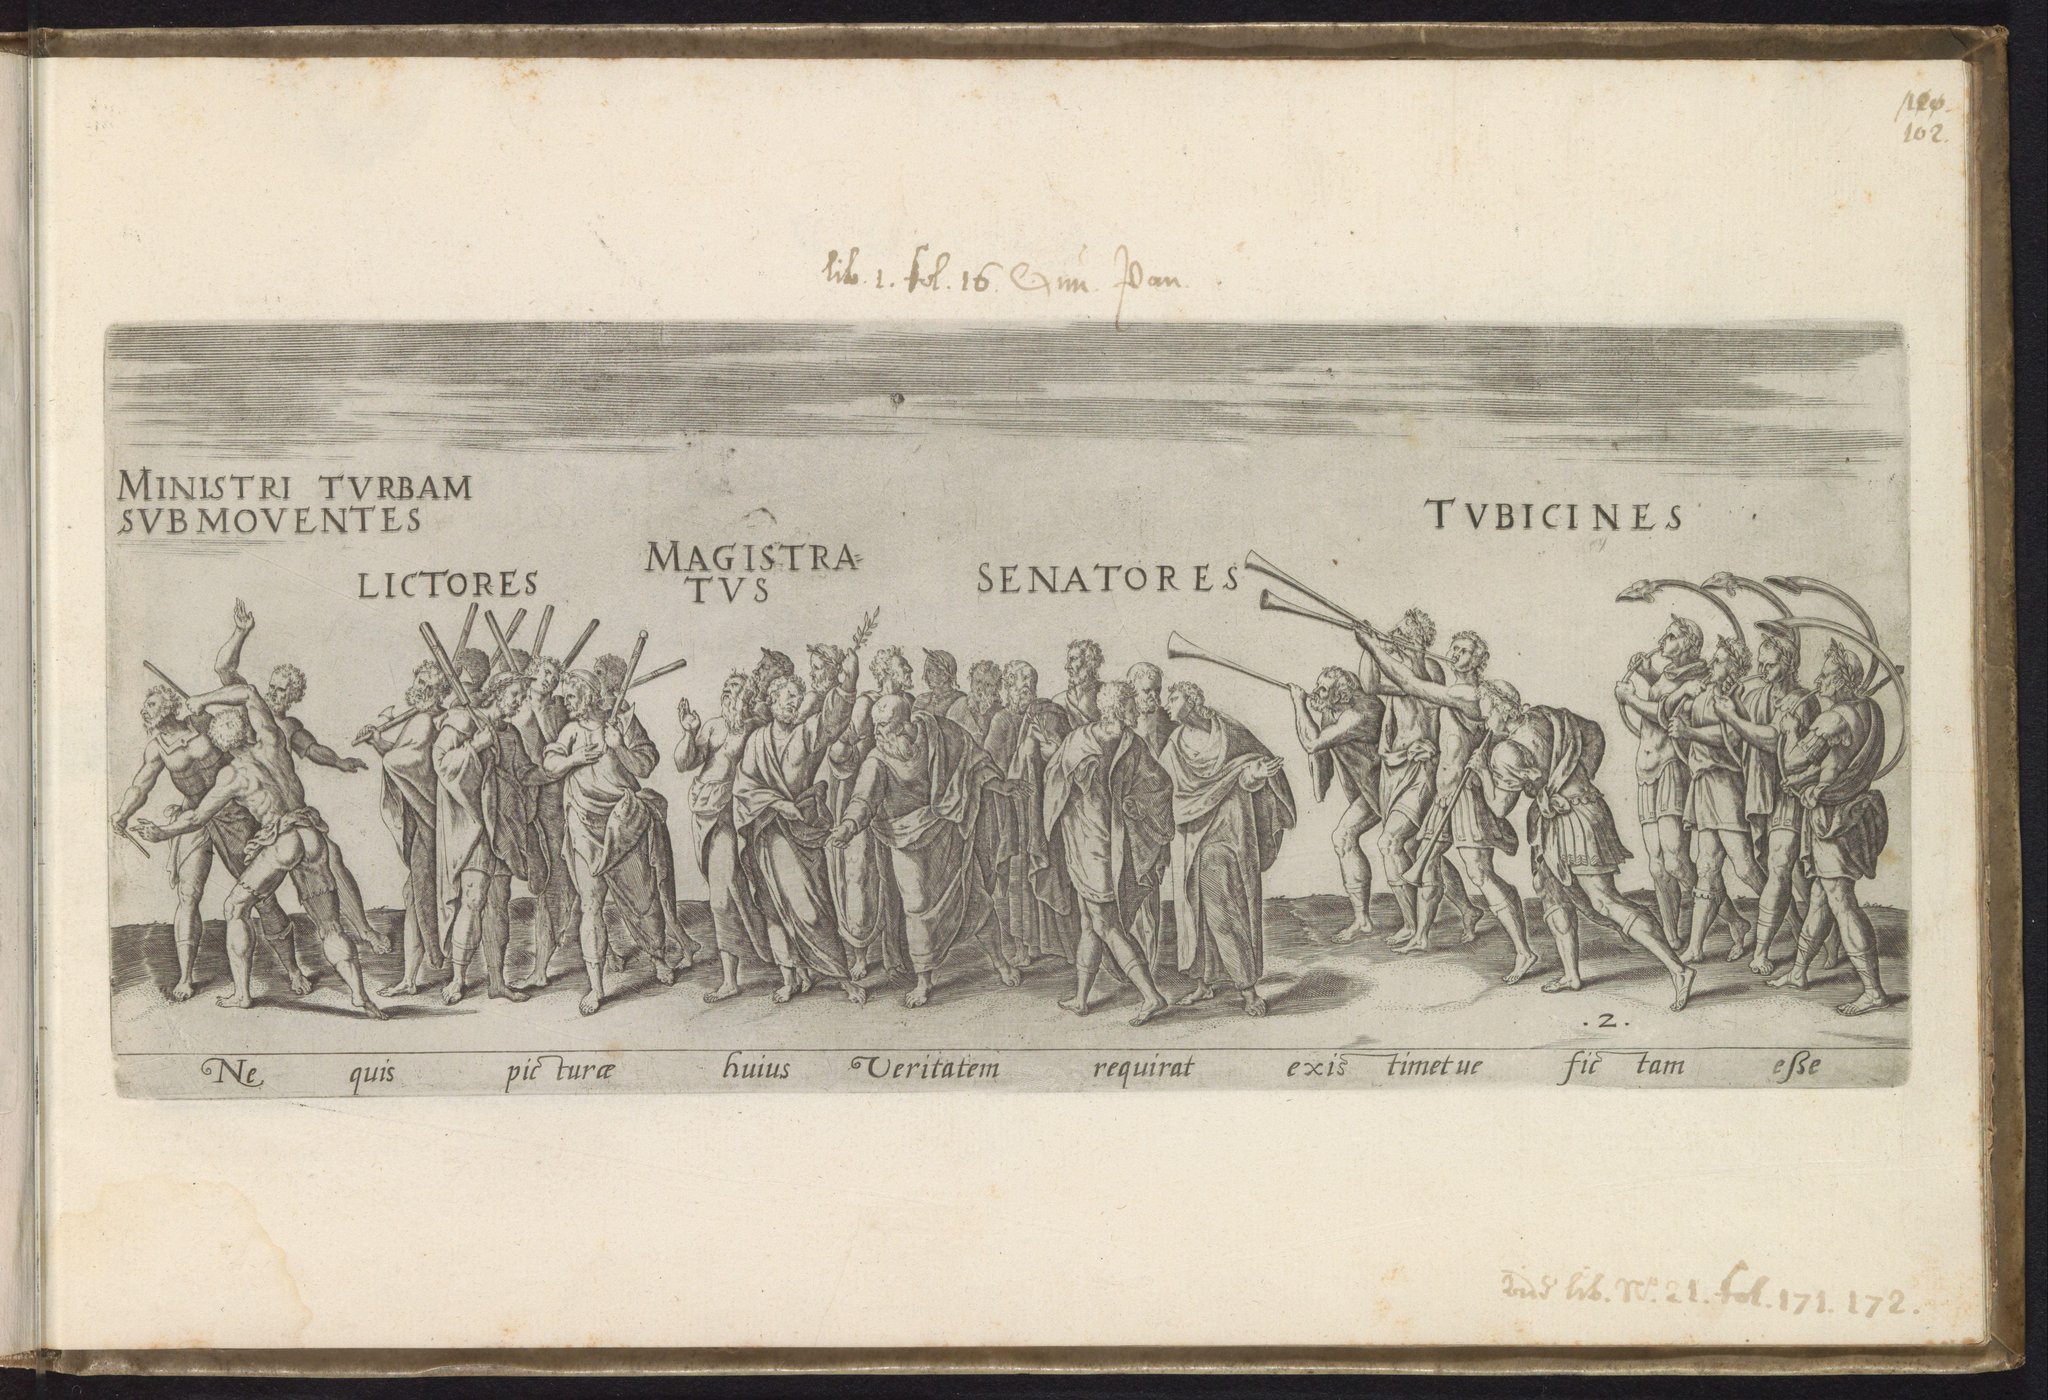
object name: print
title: Triomf processie met inwoners van Rome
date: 1618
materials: paper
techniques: engraving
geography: rome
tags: ceremonial procession, parade, pageant ~ installation of a ruler, musician, politician, e.g. party leader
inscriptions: inscription: ‘lib. 1. fol. 16 [...]’, inscription: ‘Ende lib. No. 21. fol. 171. 172.’, number: ‘102’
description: Processie van inwoners van Rome, lictors, magistraten, senatoren en trompetspelers. Titel in het Latijn in ondermarge. Prent maakt deel uit van een album.